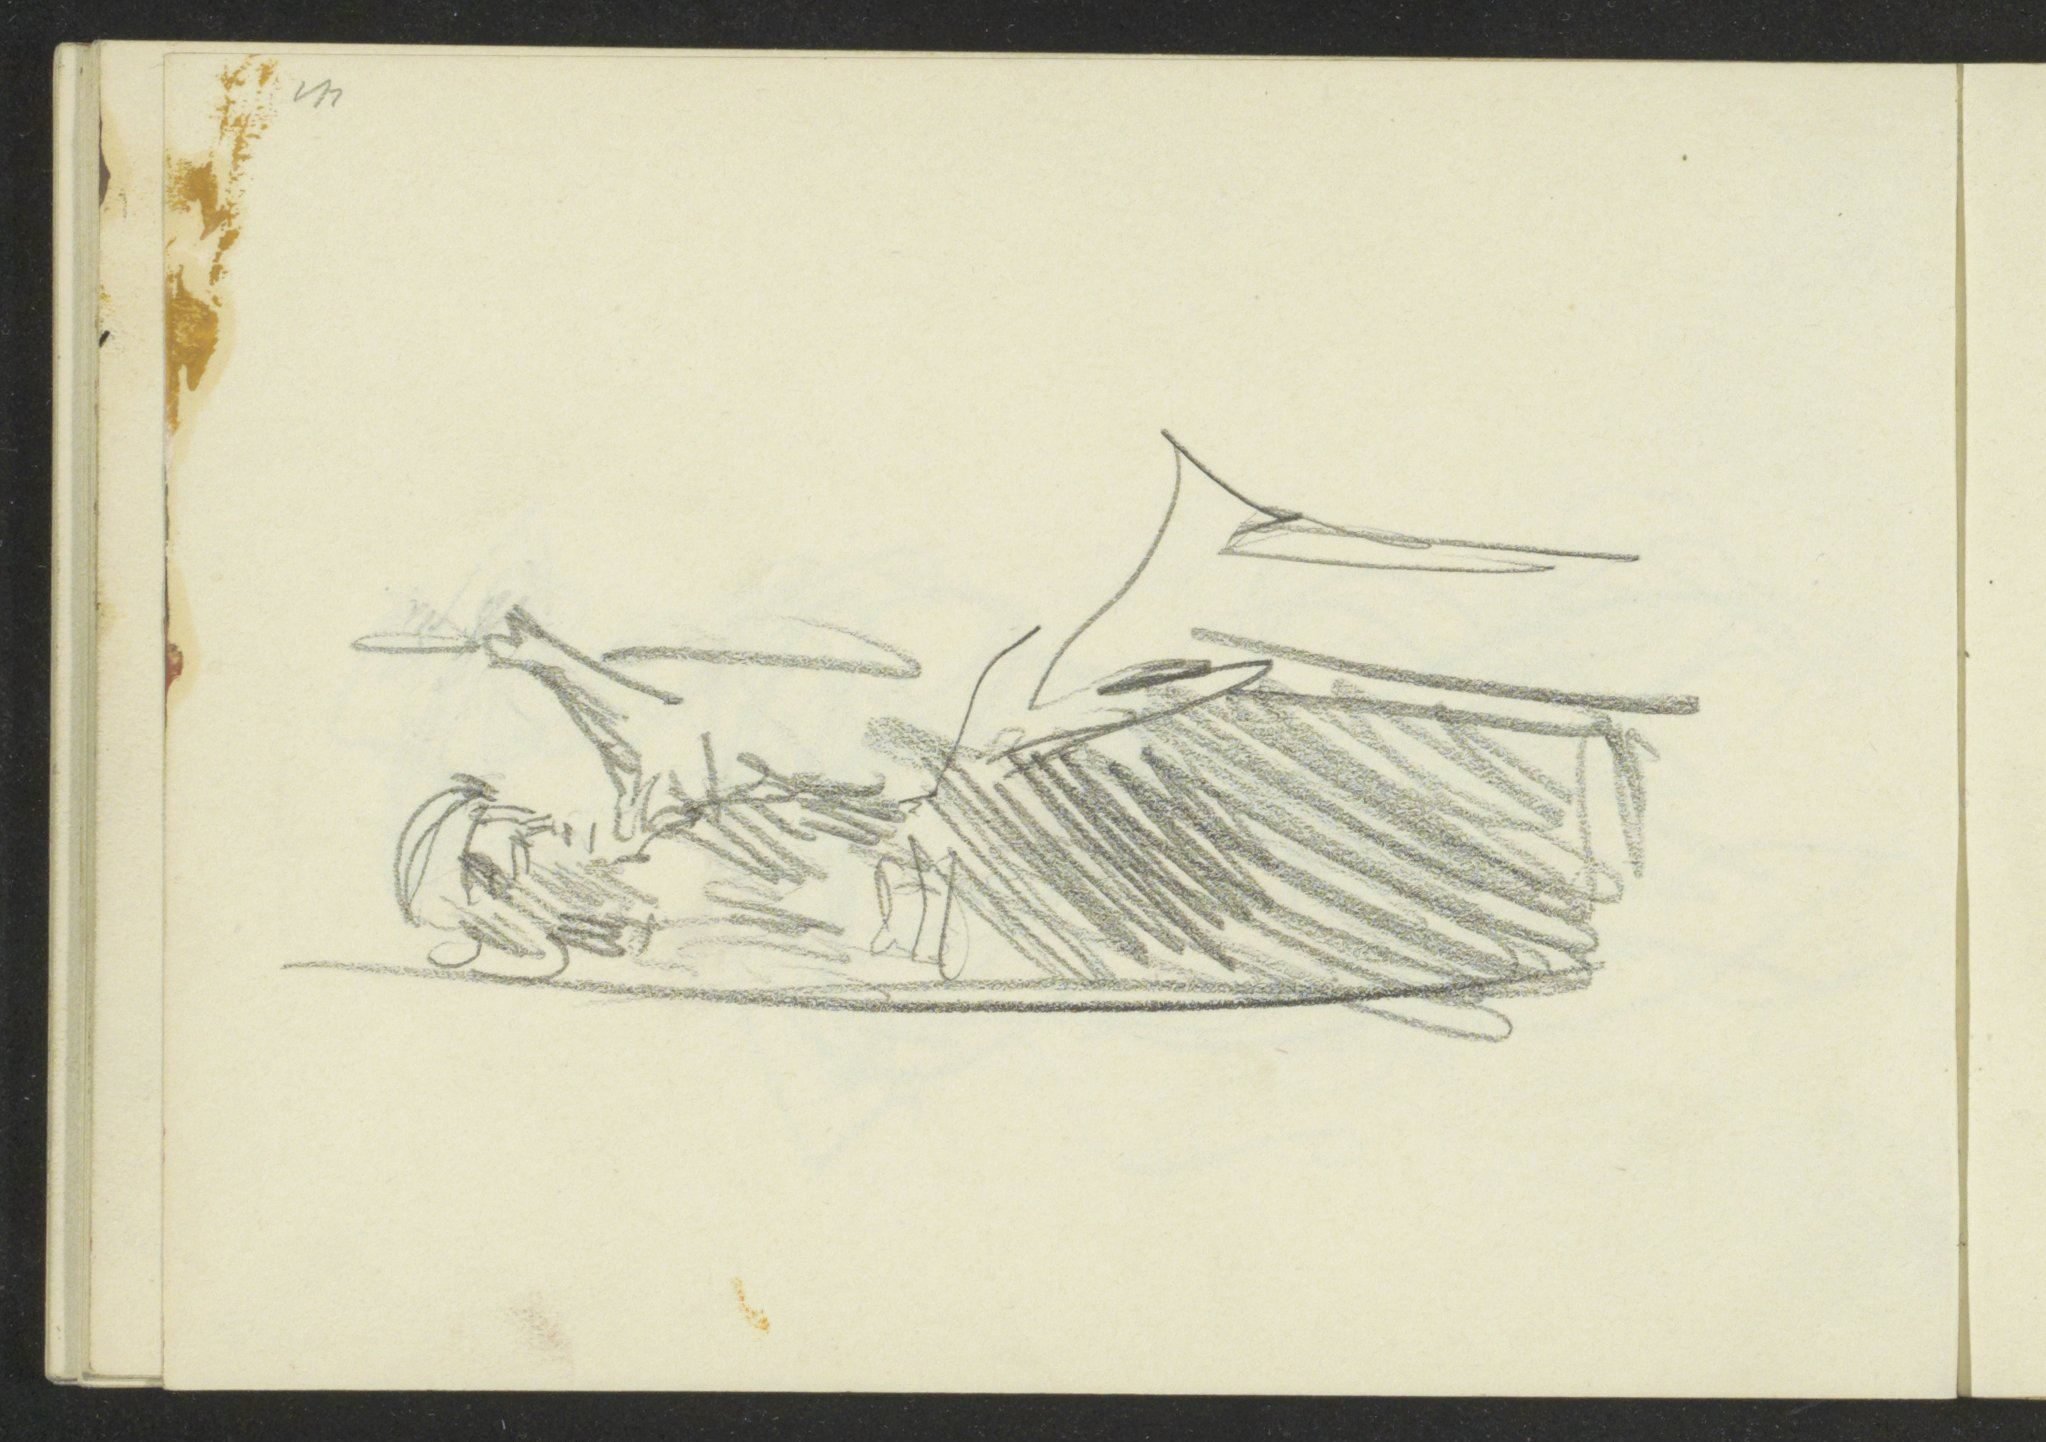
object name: sketchbook leaf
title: Staande vrouw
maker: isaac israels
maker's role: draughtsman, painter, print maker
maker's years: 1865-1934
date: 1875-1934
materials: paper, pencil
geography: the hague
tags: adult woman (+ standing)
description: Ze staat mogelijk in een smalle ruimte. Blad 18 verso uit schetsboek LVII met 29 bladen.